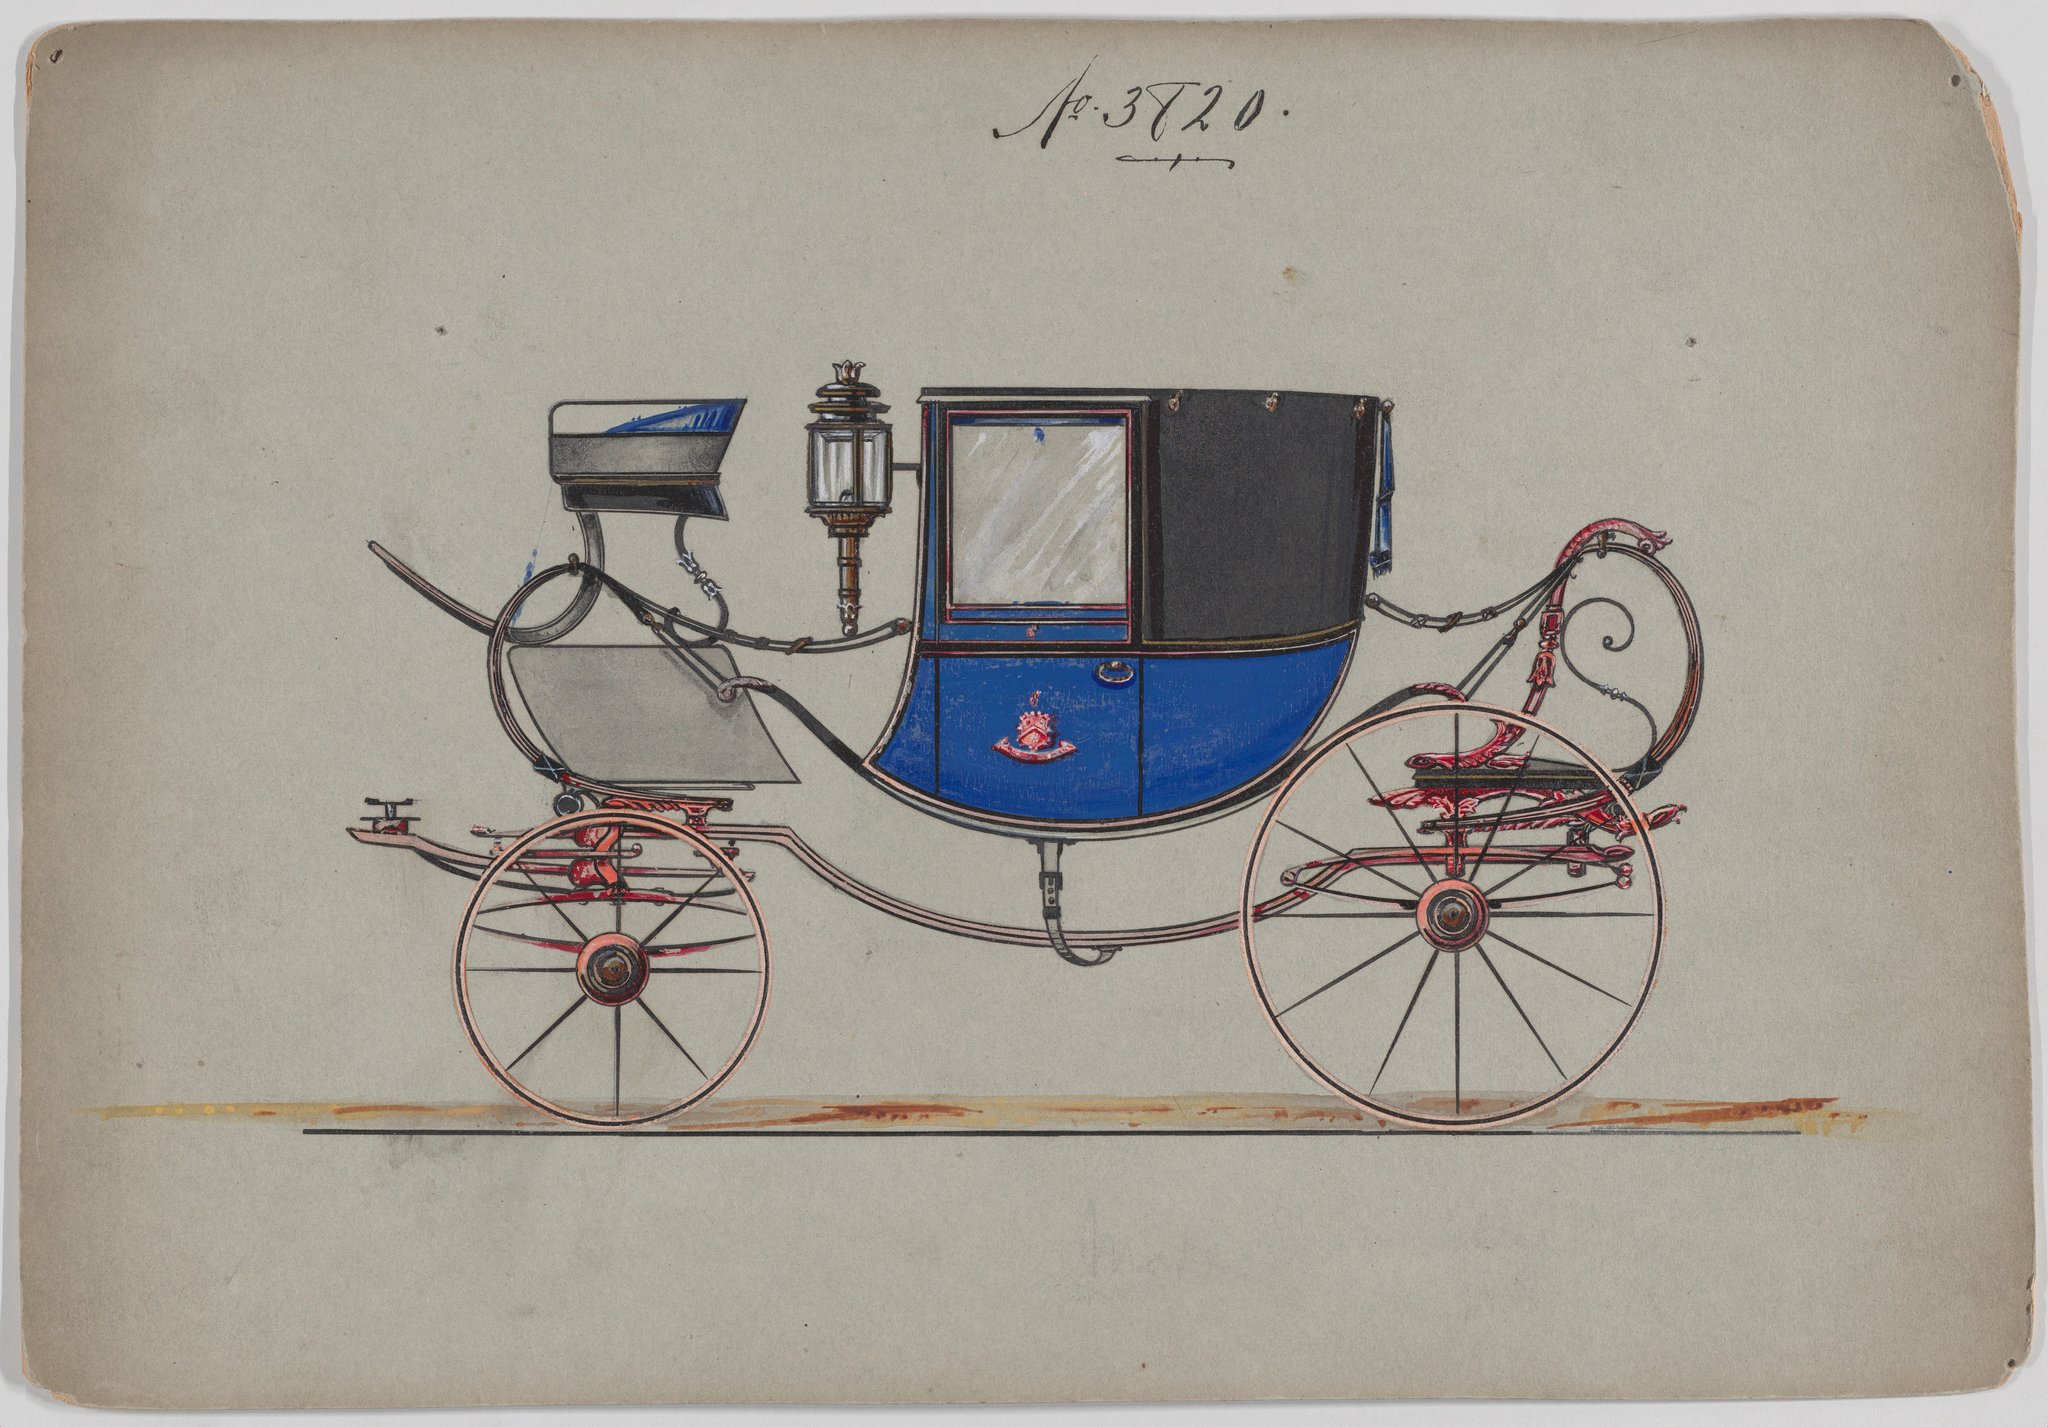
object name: drawing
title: Design for Brougham, no. 3820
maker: brewster & co.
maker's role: manufacturer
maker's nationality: american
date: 1883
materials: gouache, gum arabic, ink, paint, watercolor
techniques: pen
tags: carriages